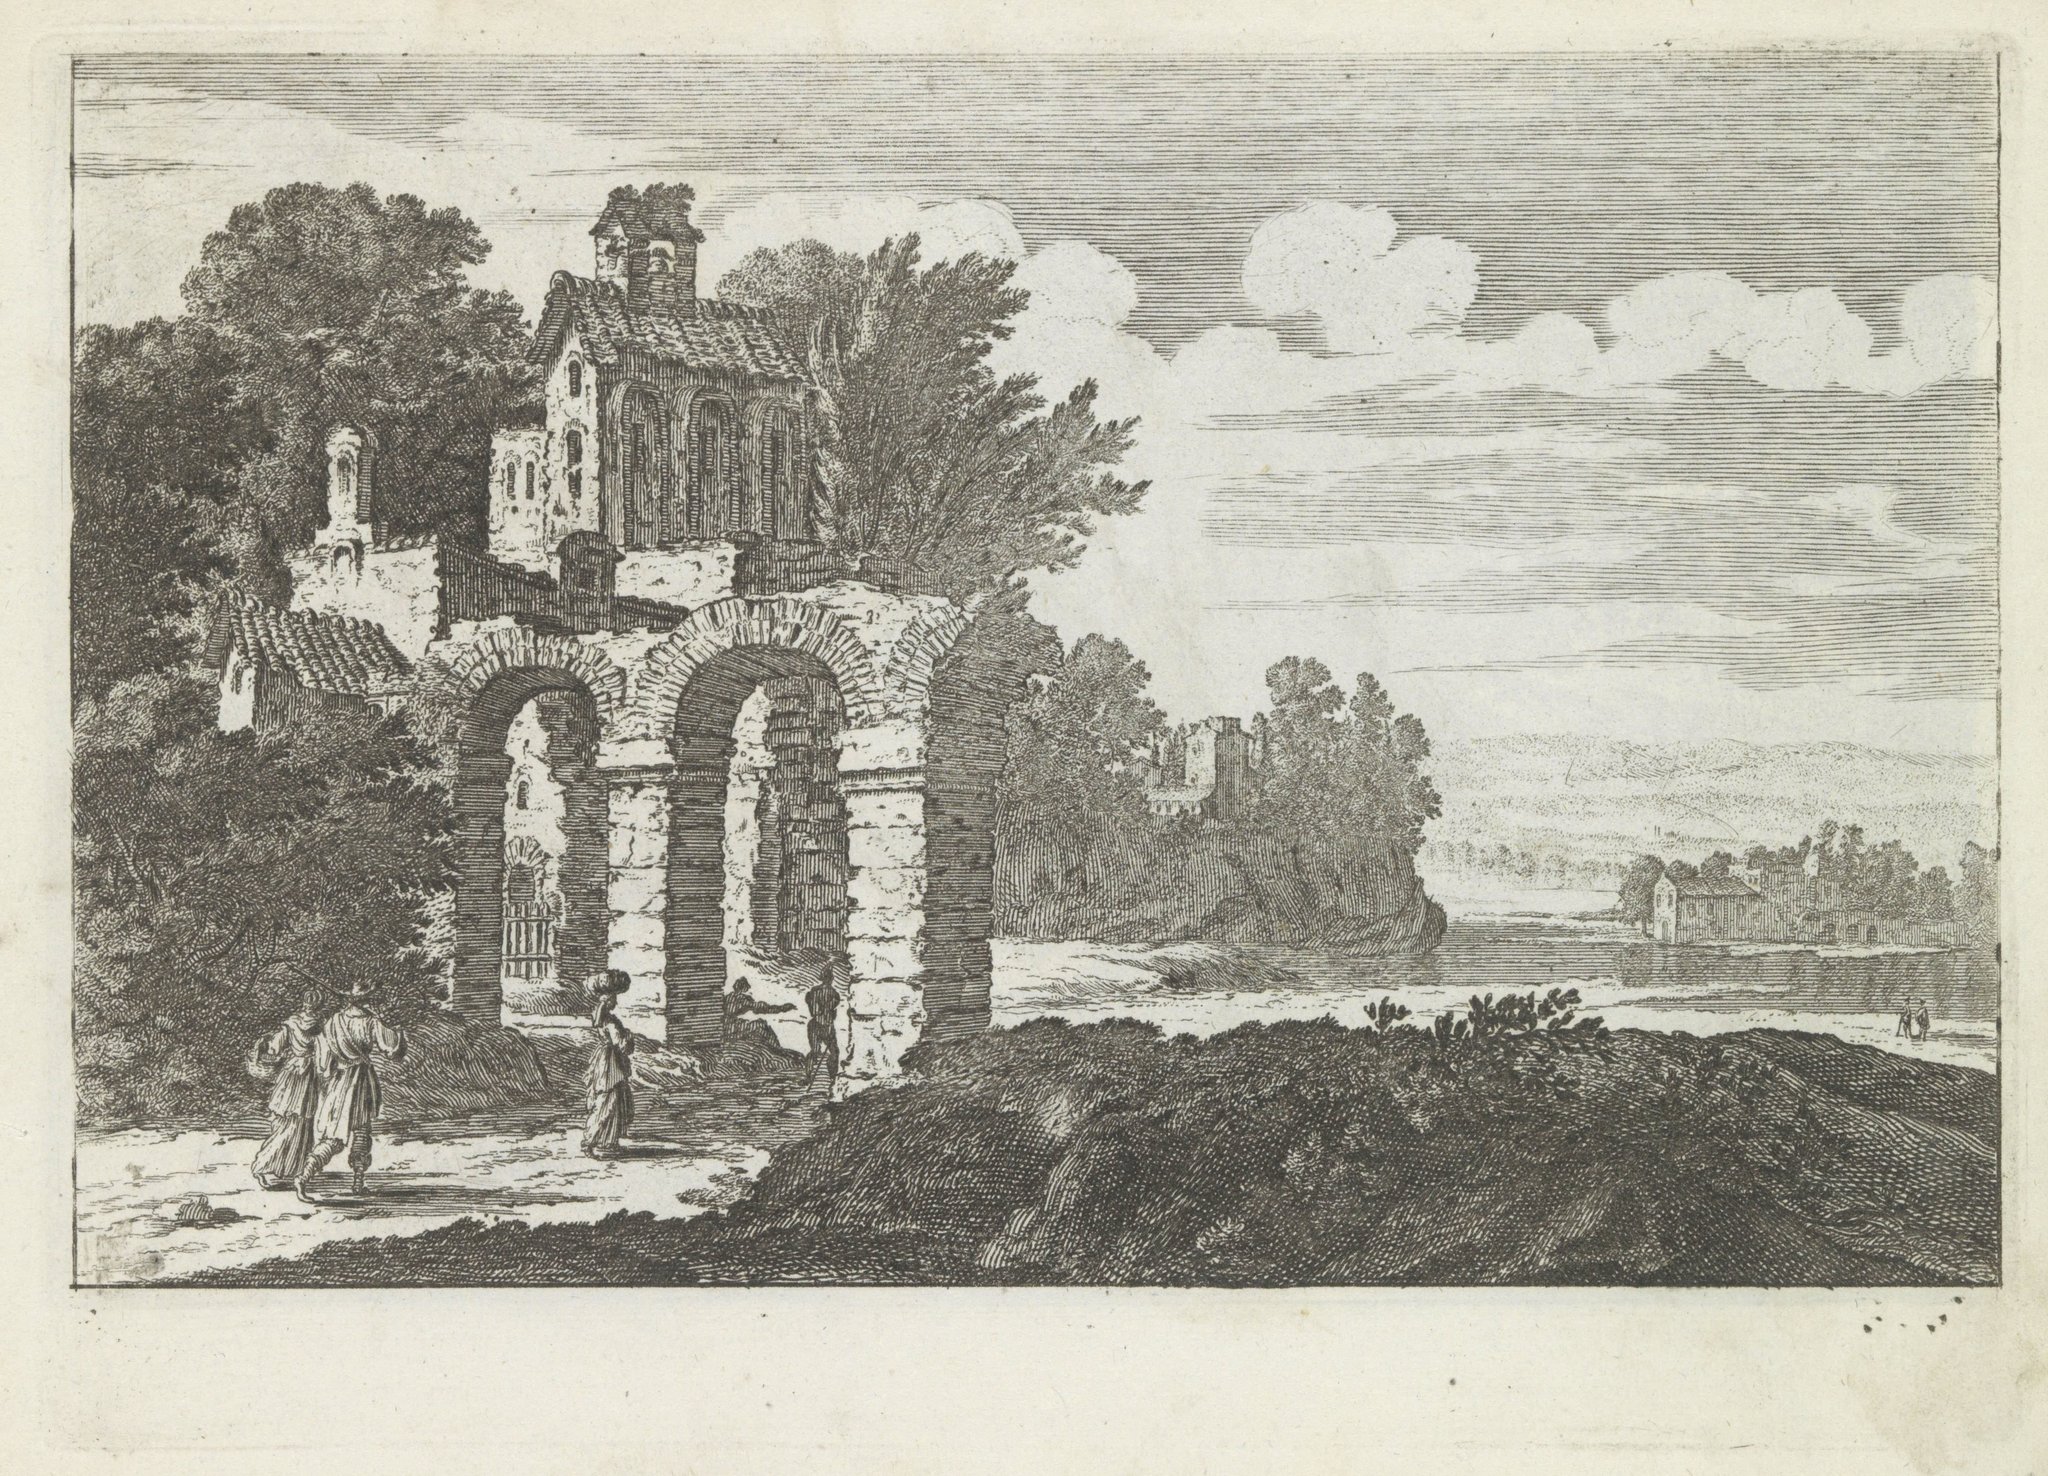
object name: print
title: Landschap met links een ruïne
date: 1641-1695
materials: paper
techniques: etching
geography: amsterdam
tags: landscapes in the temperate zone, landscape with ruins (+ city(-scape) with figures, staffage)